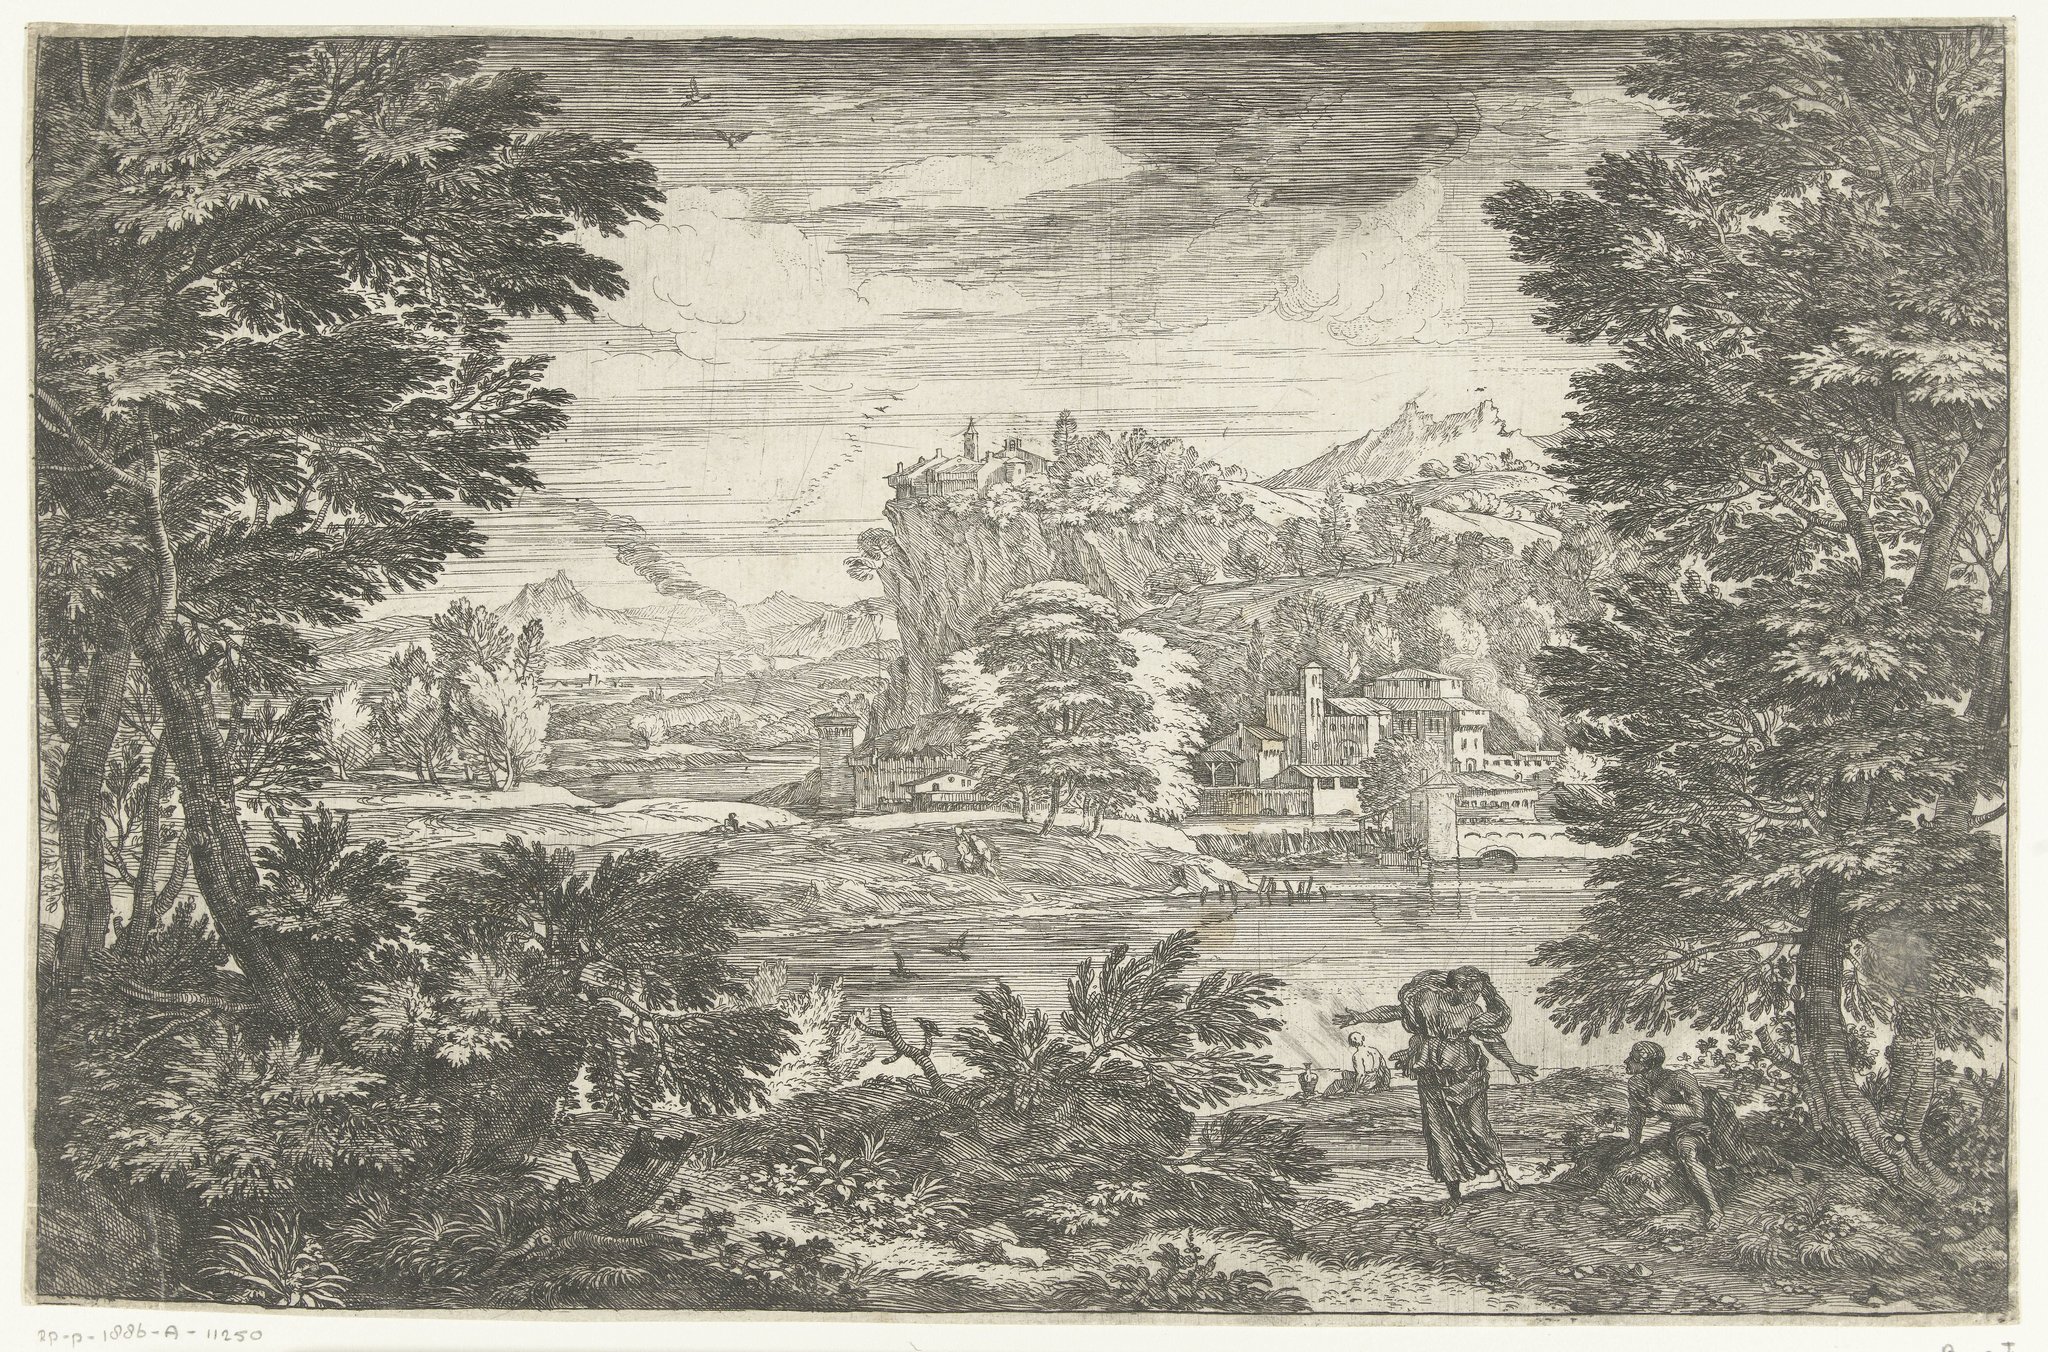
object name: print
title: Landschap met man zittend onder boom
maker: adriaen van der kabel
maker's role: draughtsman, painter, print maker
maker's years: 1630-1705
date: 1648-1705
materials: paper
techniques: etching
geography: france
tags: landscapes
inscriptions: collector's mark: Lugt 2228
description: Landschap met vrouw, de armen gespreid, staand bij onder boom zittende man. Op de achtergrond een dorp aan een meer. Vijfde prent uit de serie van zes.